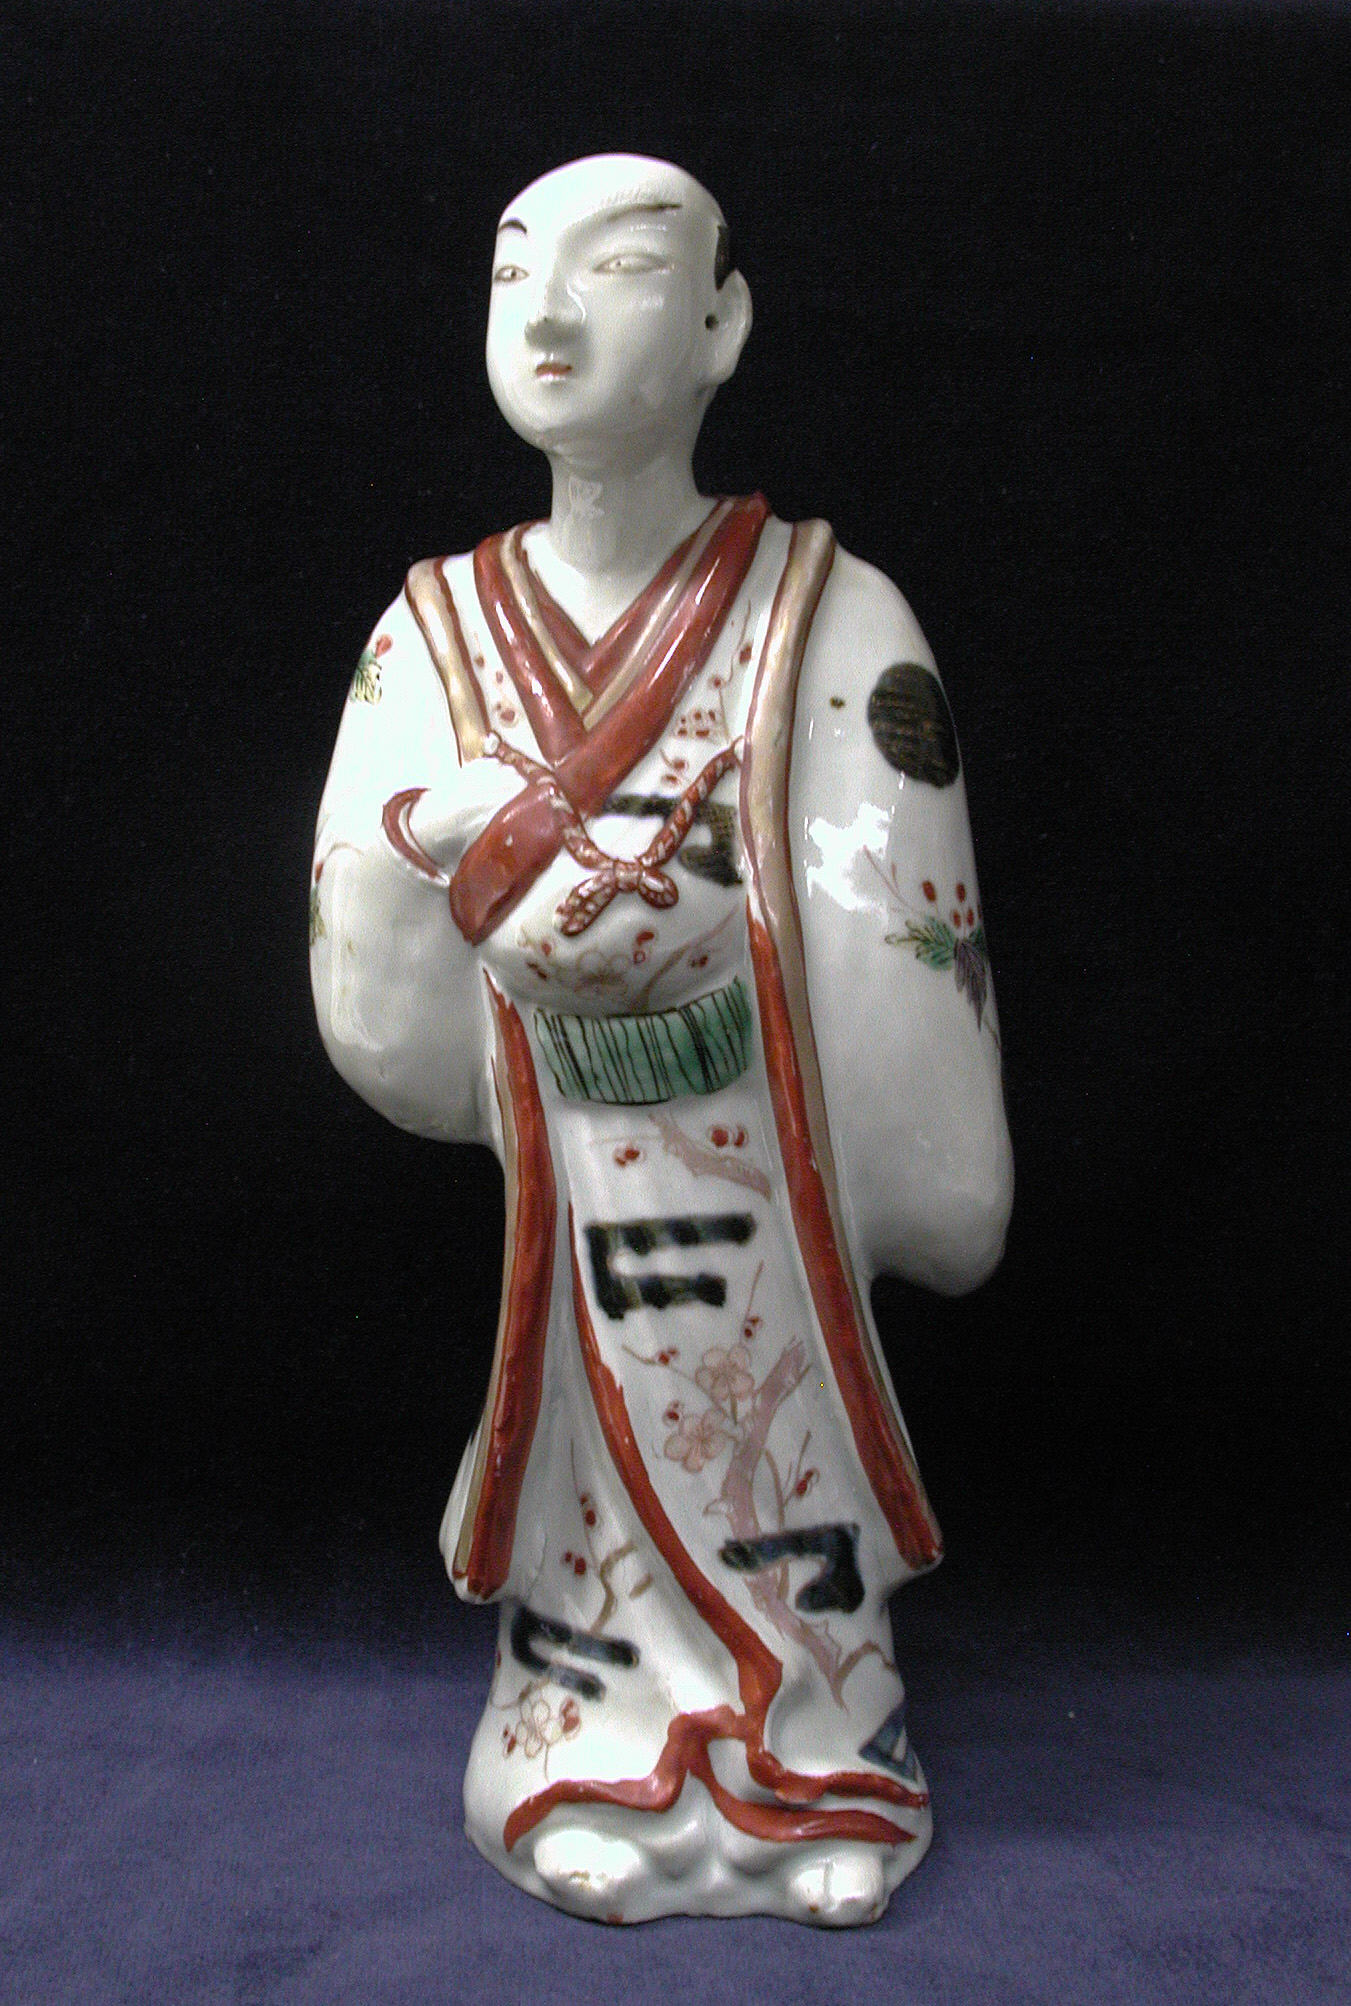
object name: figure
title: Kabuki actor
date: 1700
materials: enamel, glaze, hard paste porcelain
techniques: painting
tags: men,actors